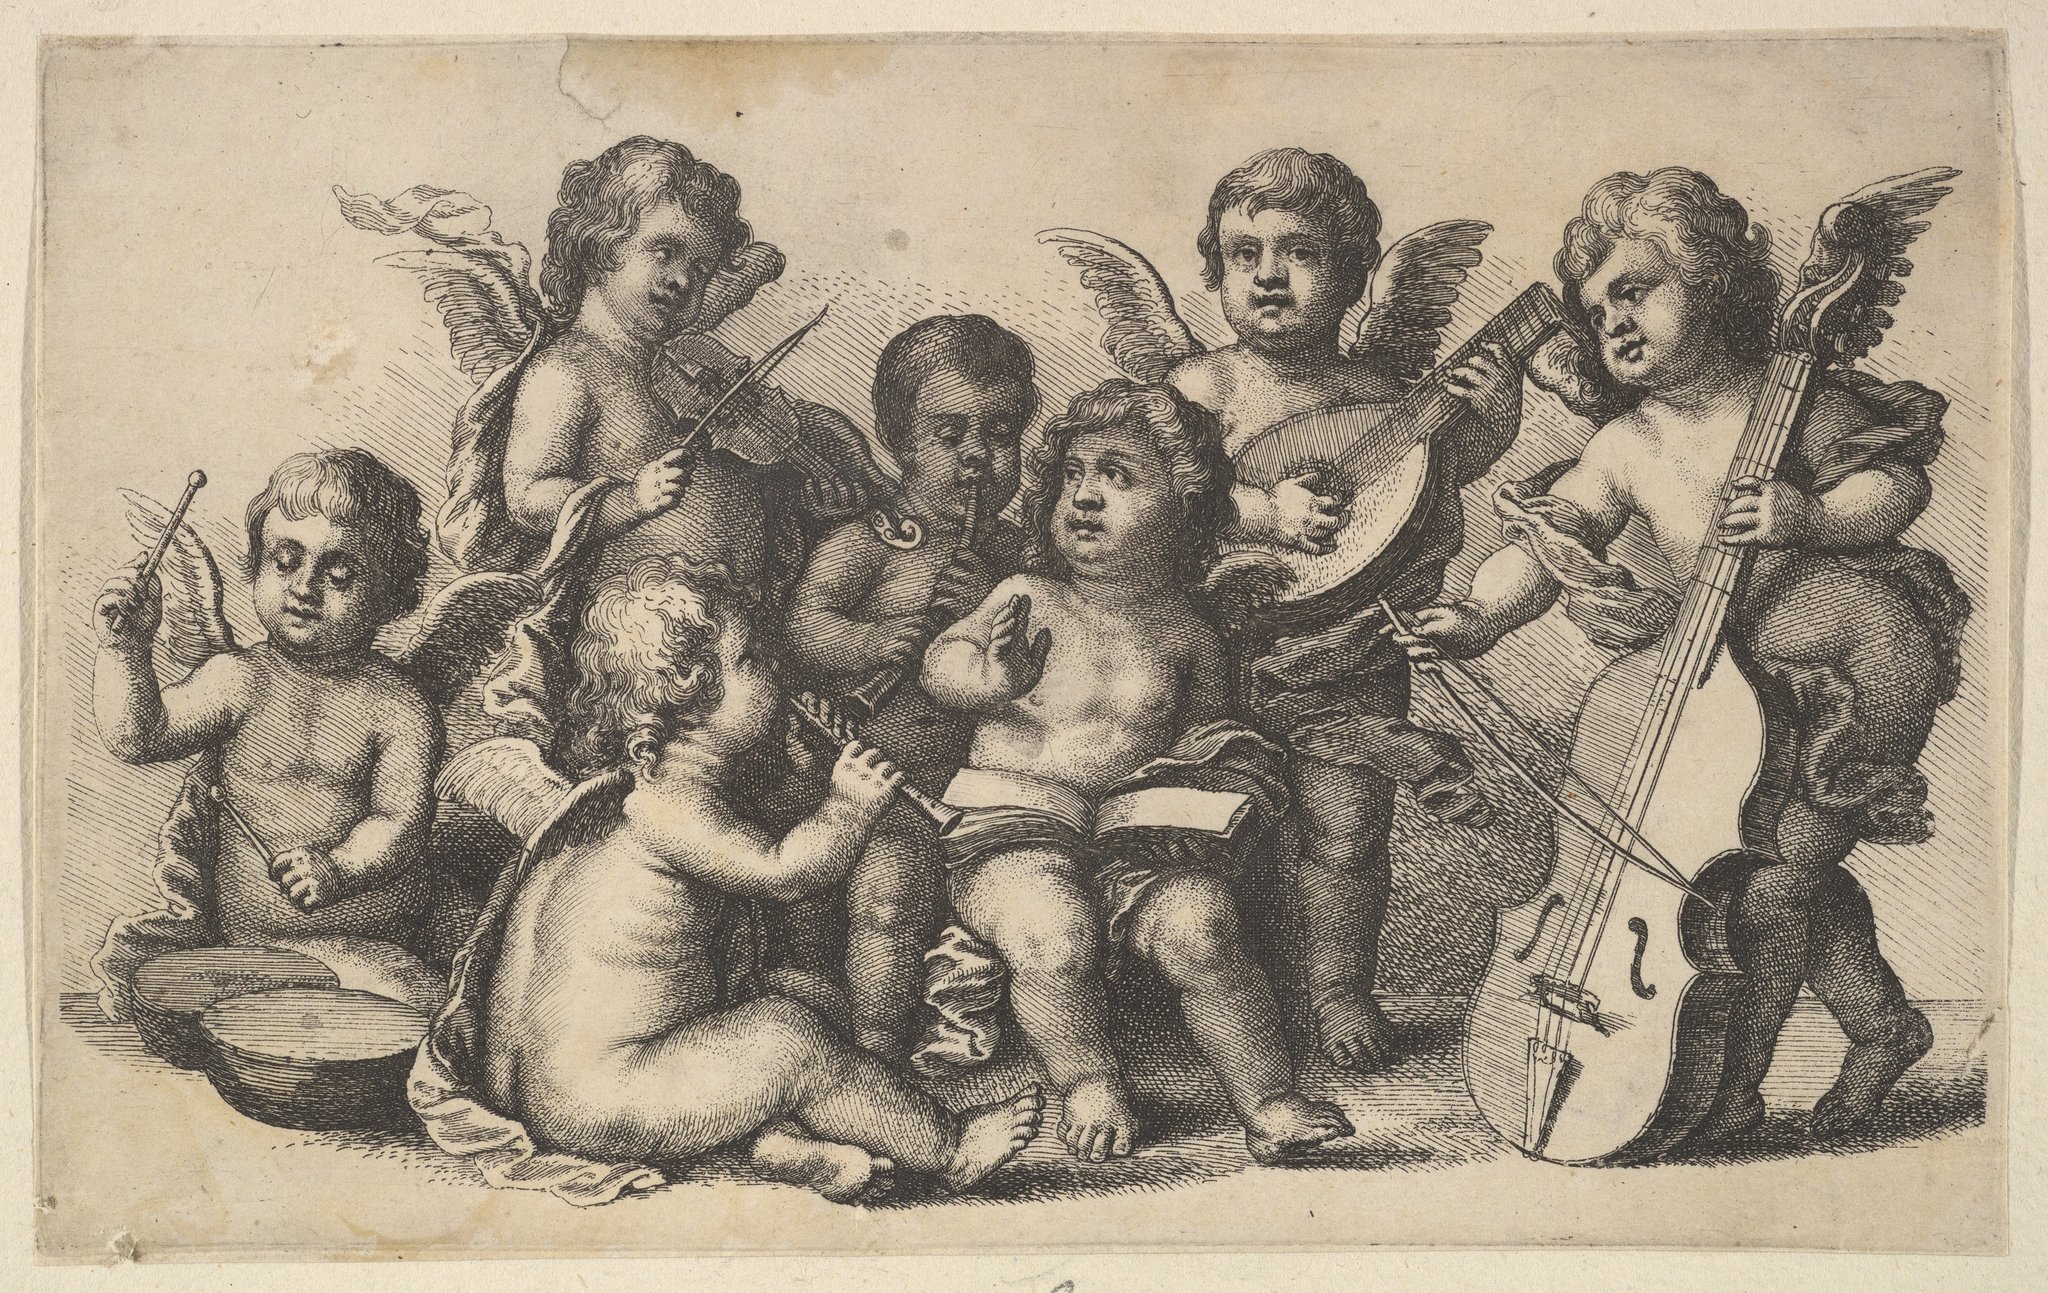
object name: print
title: Concert of cherubs on Earth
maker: wenceslaus hollar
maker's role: artist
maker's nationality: bohemian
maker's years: 1607-1677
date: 1646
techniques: etching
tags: violins